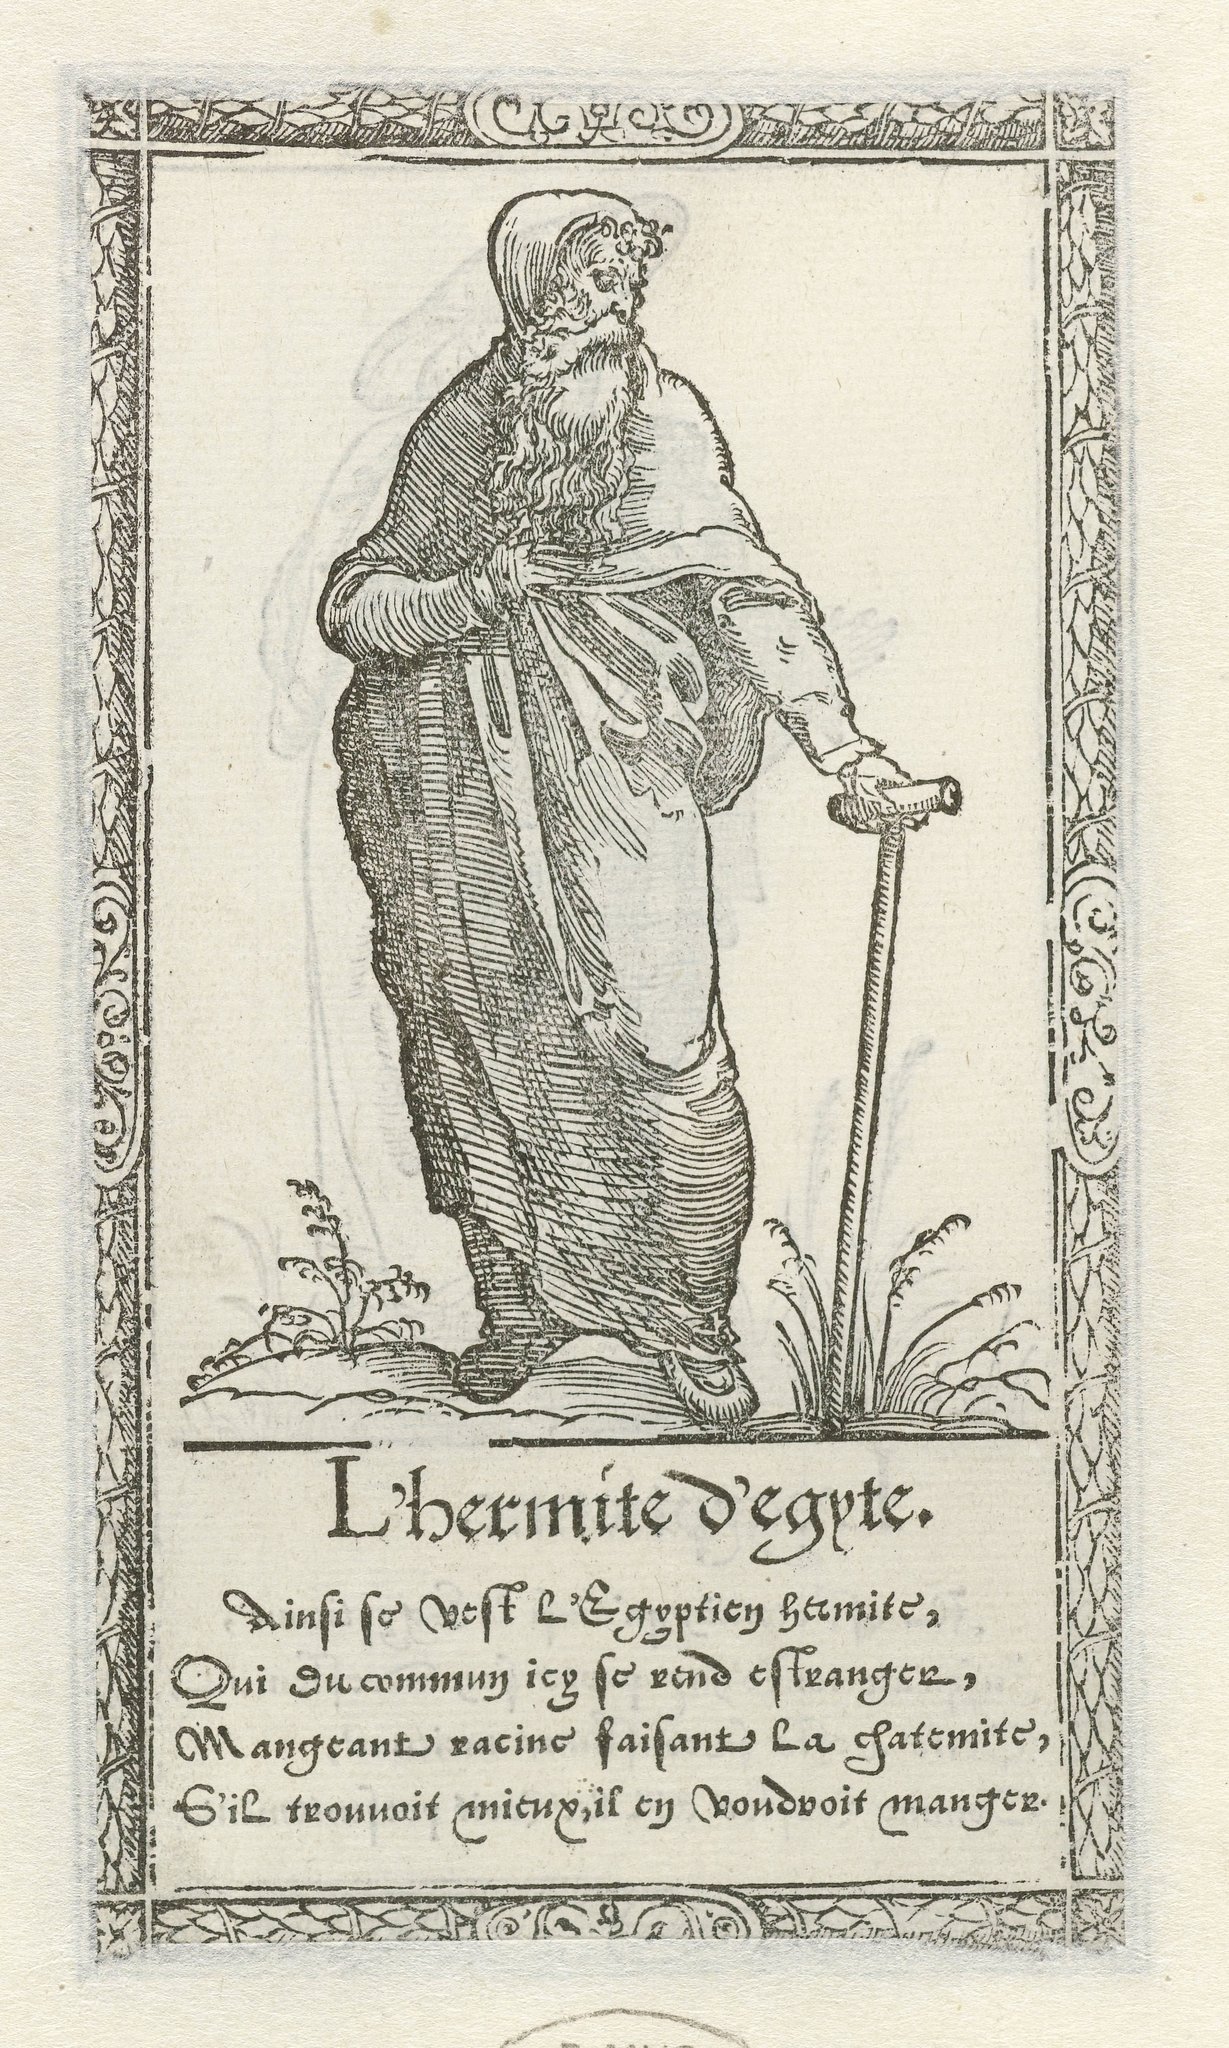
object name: print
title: L'hermite d'egypte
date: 1562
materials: paper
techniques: woodcut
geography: paris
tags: africans, anchorite, hermit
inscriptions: collector's mark: Lugt 2228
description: Dit is prent 100 uit een serie van 121. Binnen deze serie zijn er prenten gemaakt naar voorbeelden van Jean-François de Roberval en Enea Vico, onbekend welke precies.